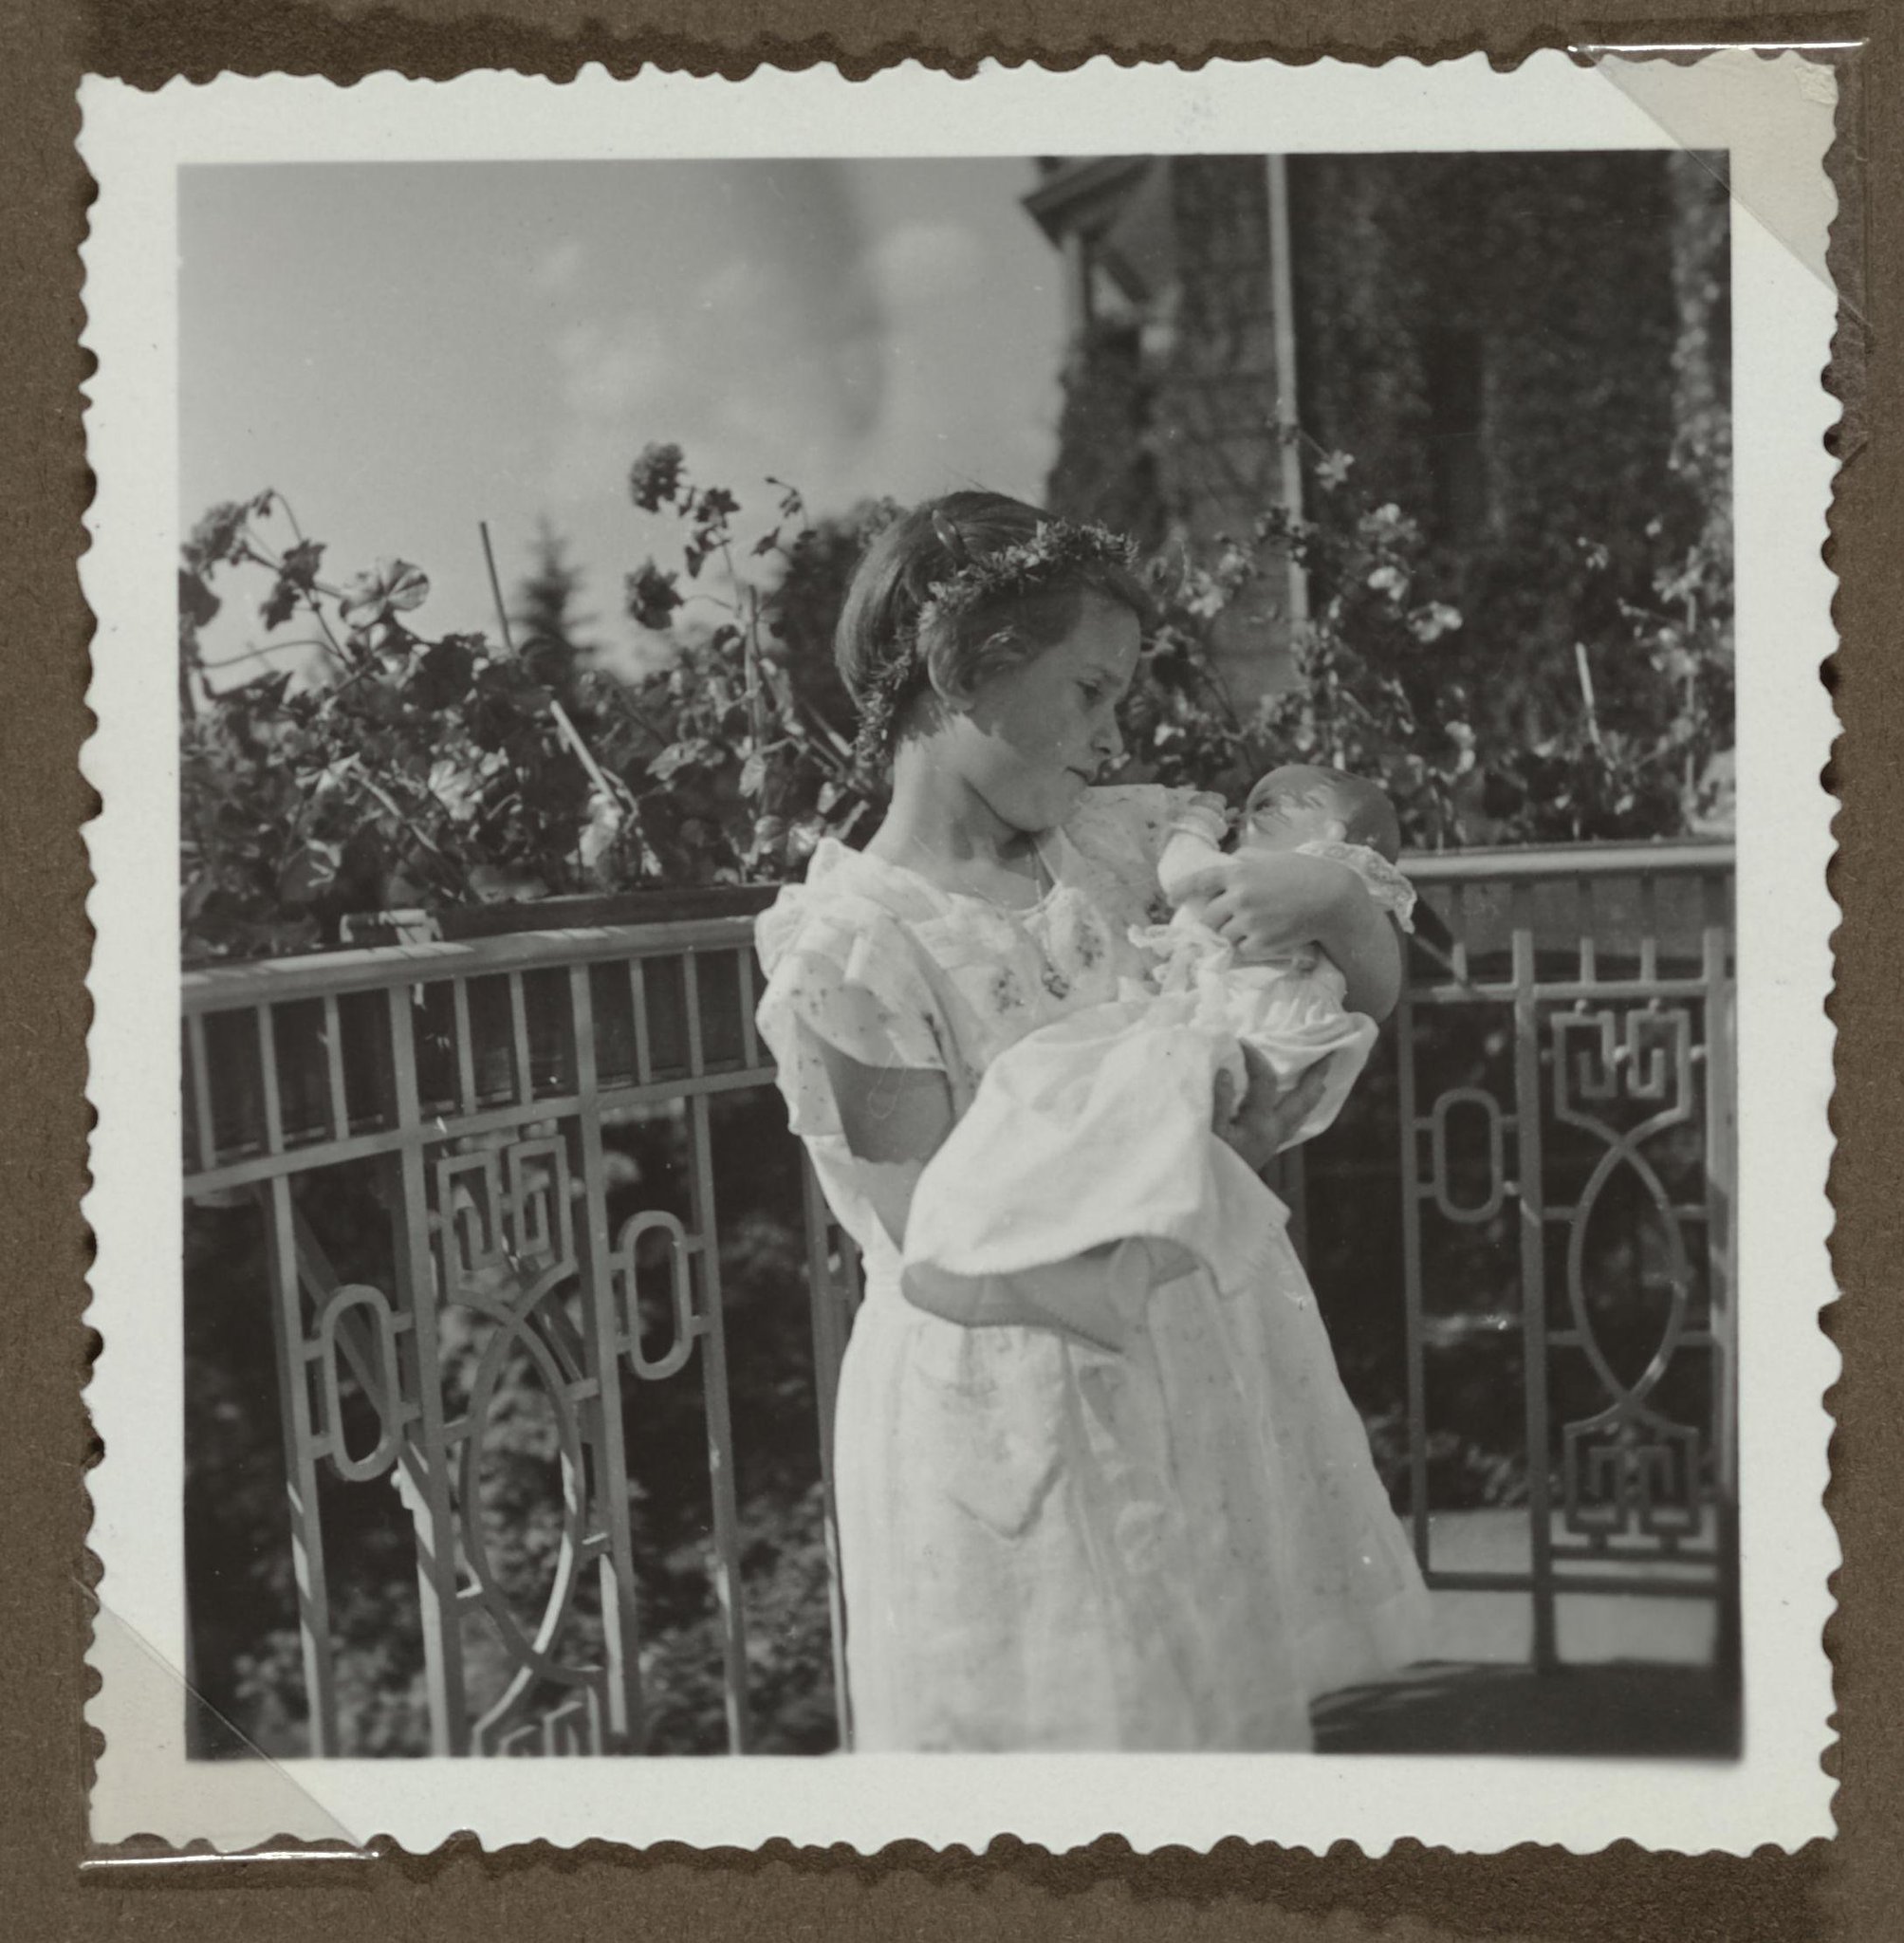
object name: photograph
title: Isabel Wachenheimer tijdens haar verjaardag met pop in de hand op balkon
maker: Anonymous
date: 1932-1937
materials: photographic support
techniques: gelatin silver print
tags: isabel wachenheimer-elon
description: Dit object is onderdeel van de nalatenschap van Isabel Elon-Wachenheimer (1928-2010). Tot haar overlijden behoorde het samen met de andere objecten uit de nalatenschap tot haar privédomein van Isabel Wachenheimer. In die particuliere context zijn deze objecten tezamen en individueel aandenkens - aan de jeugd, ouders en familie van Isabel Wachenheimer vóór en tijdens de Shoah en aan haar leven na de Tweede Wereldoorlog. Isabel Wachenheimer, die van juni 1943 tot mei 1945 gevangen zat in Kamp Westerbork, Theresienstadt, Auschwitz, Lenzing a/d Oberdonau (een buitenkamp van Mauthausen), overleefde de Shoah. Haar ouders – Eugène Wachenheimer en Else Wachenheimer-Moos - werden op 14 oktober 1944 in Auschwitz-Birkenau vermoord.